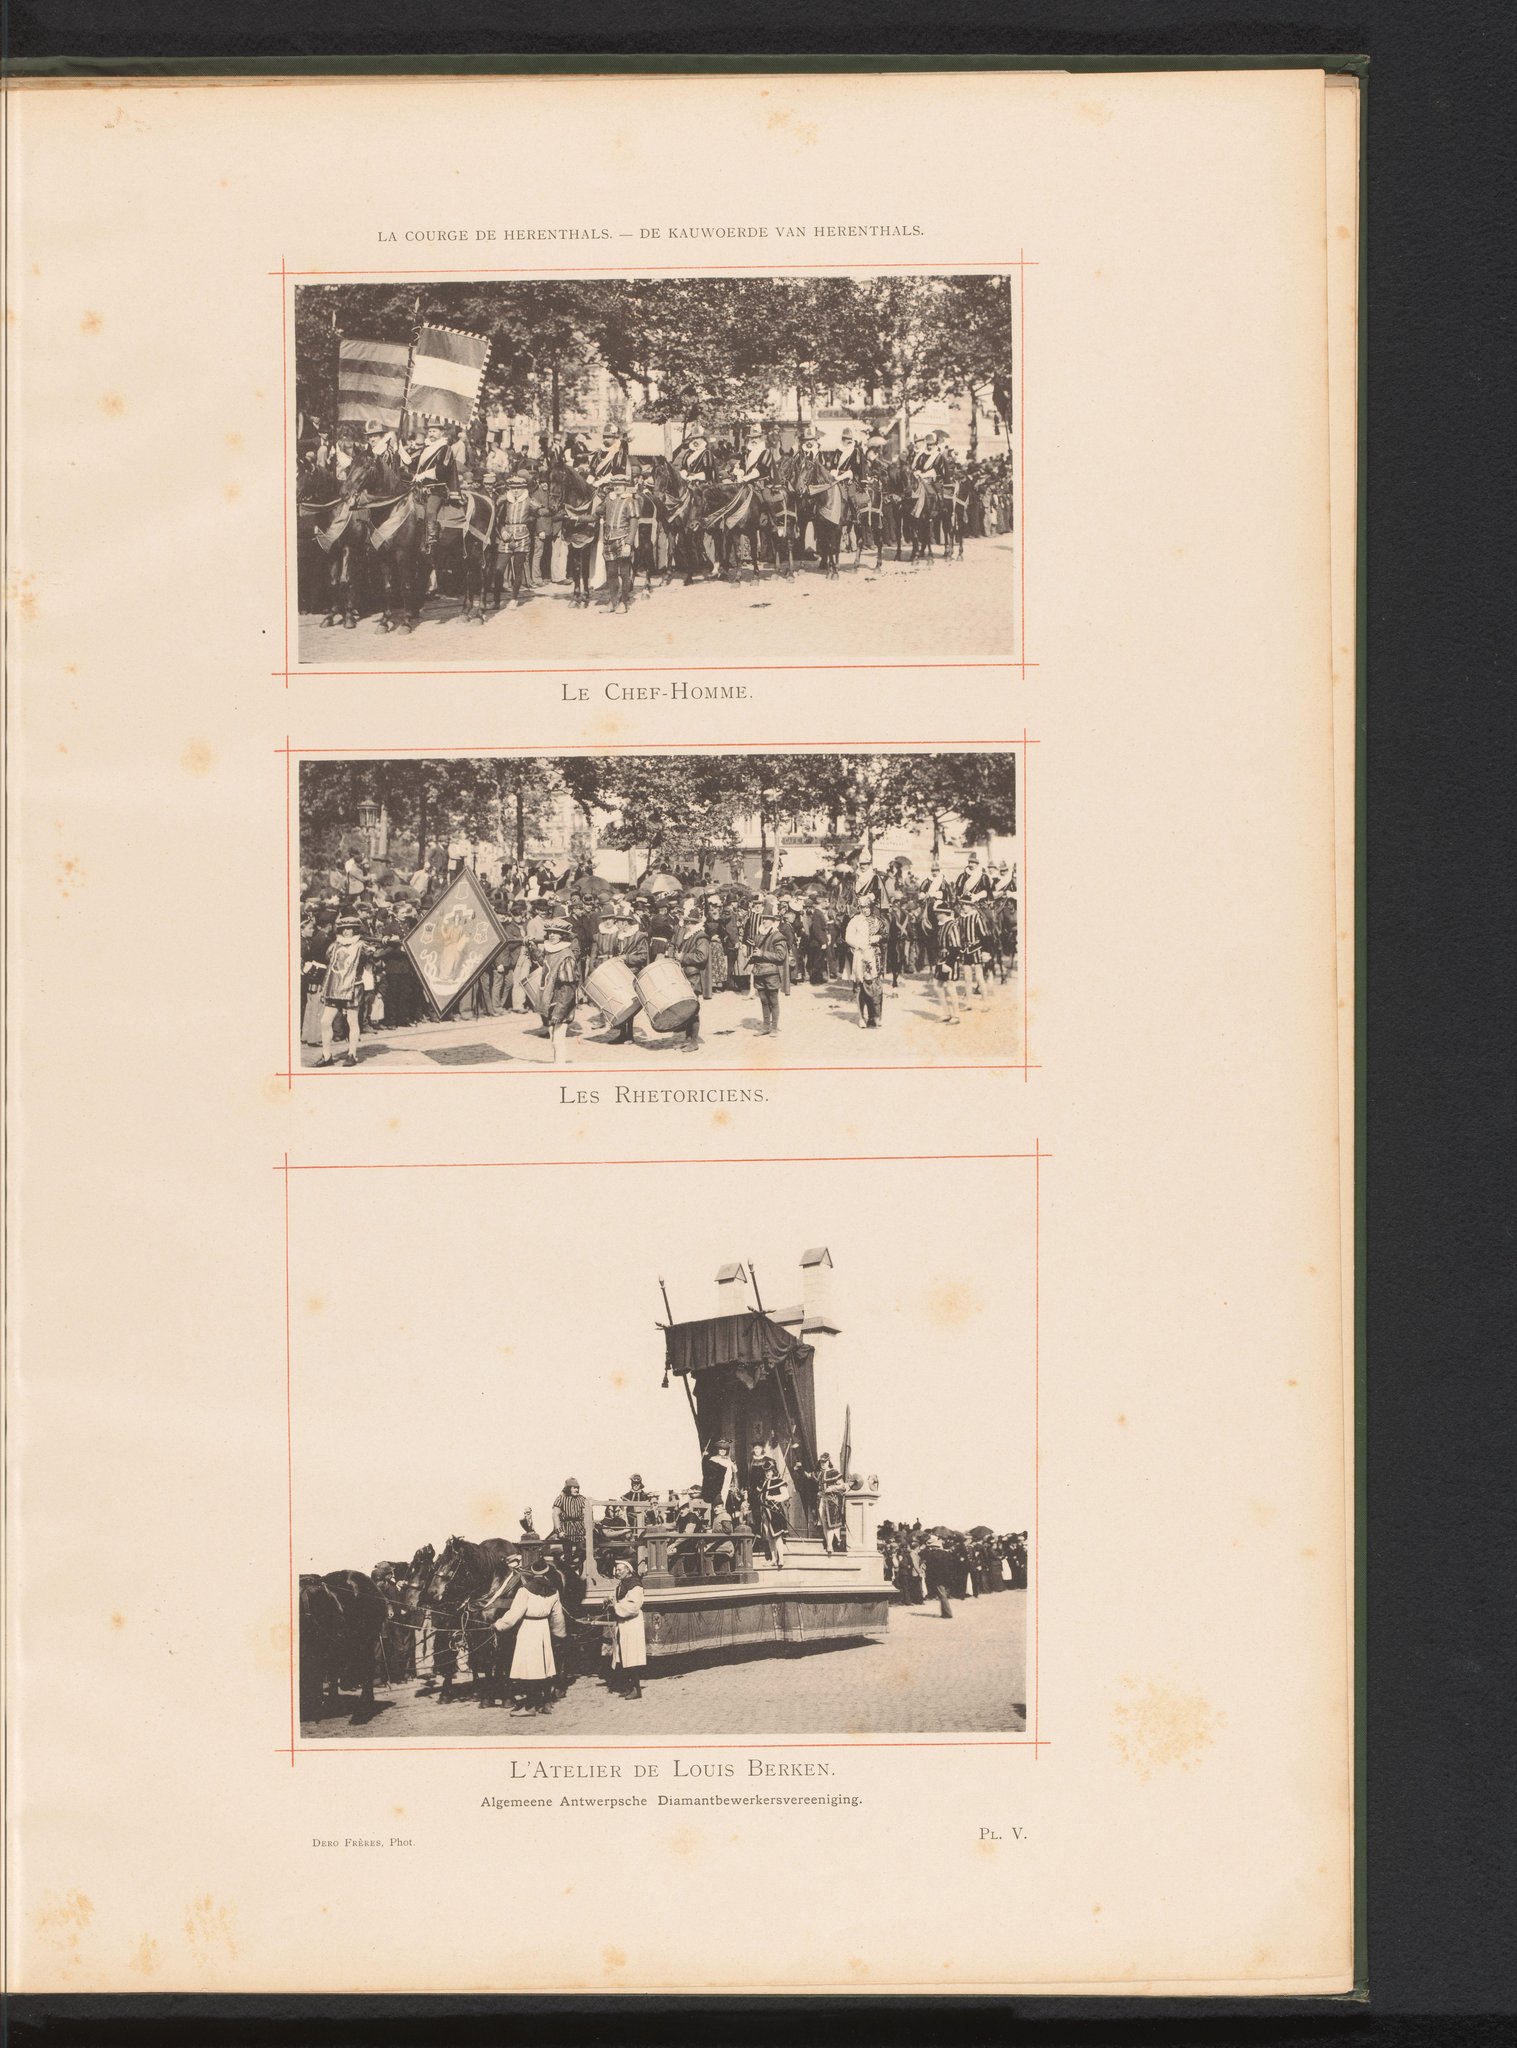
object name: page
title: Les Rhetoriciens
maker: joseph maes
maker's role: fotograaf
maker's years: 1838-1908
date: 1892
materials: paper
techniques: photograph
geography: antwerp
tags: public festivities (+ parade, pageant, cavalcade ~ festive activities), antwerp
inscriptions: number: ‘Pl. V.’, inscription: ‘LA COURGE DE HERENTHALS.- DE KAUWOERDE VAN HERENTHALS.’, inscription: ‘Algemeene Antwerpsche Diamantbewerkersvereeniging.’